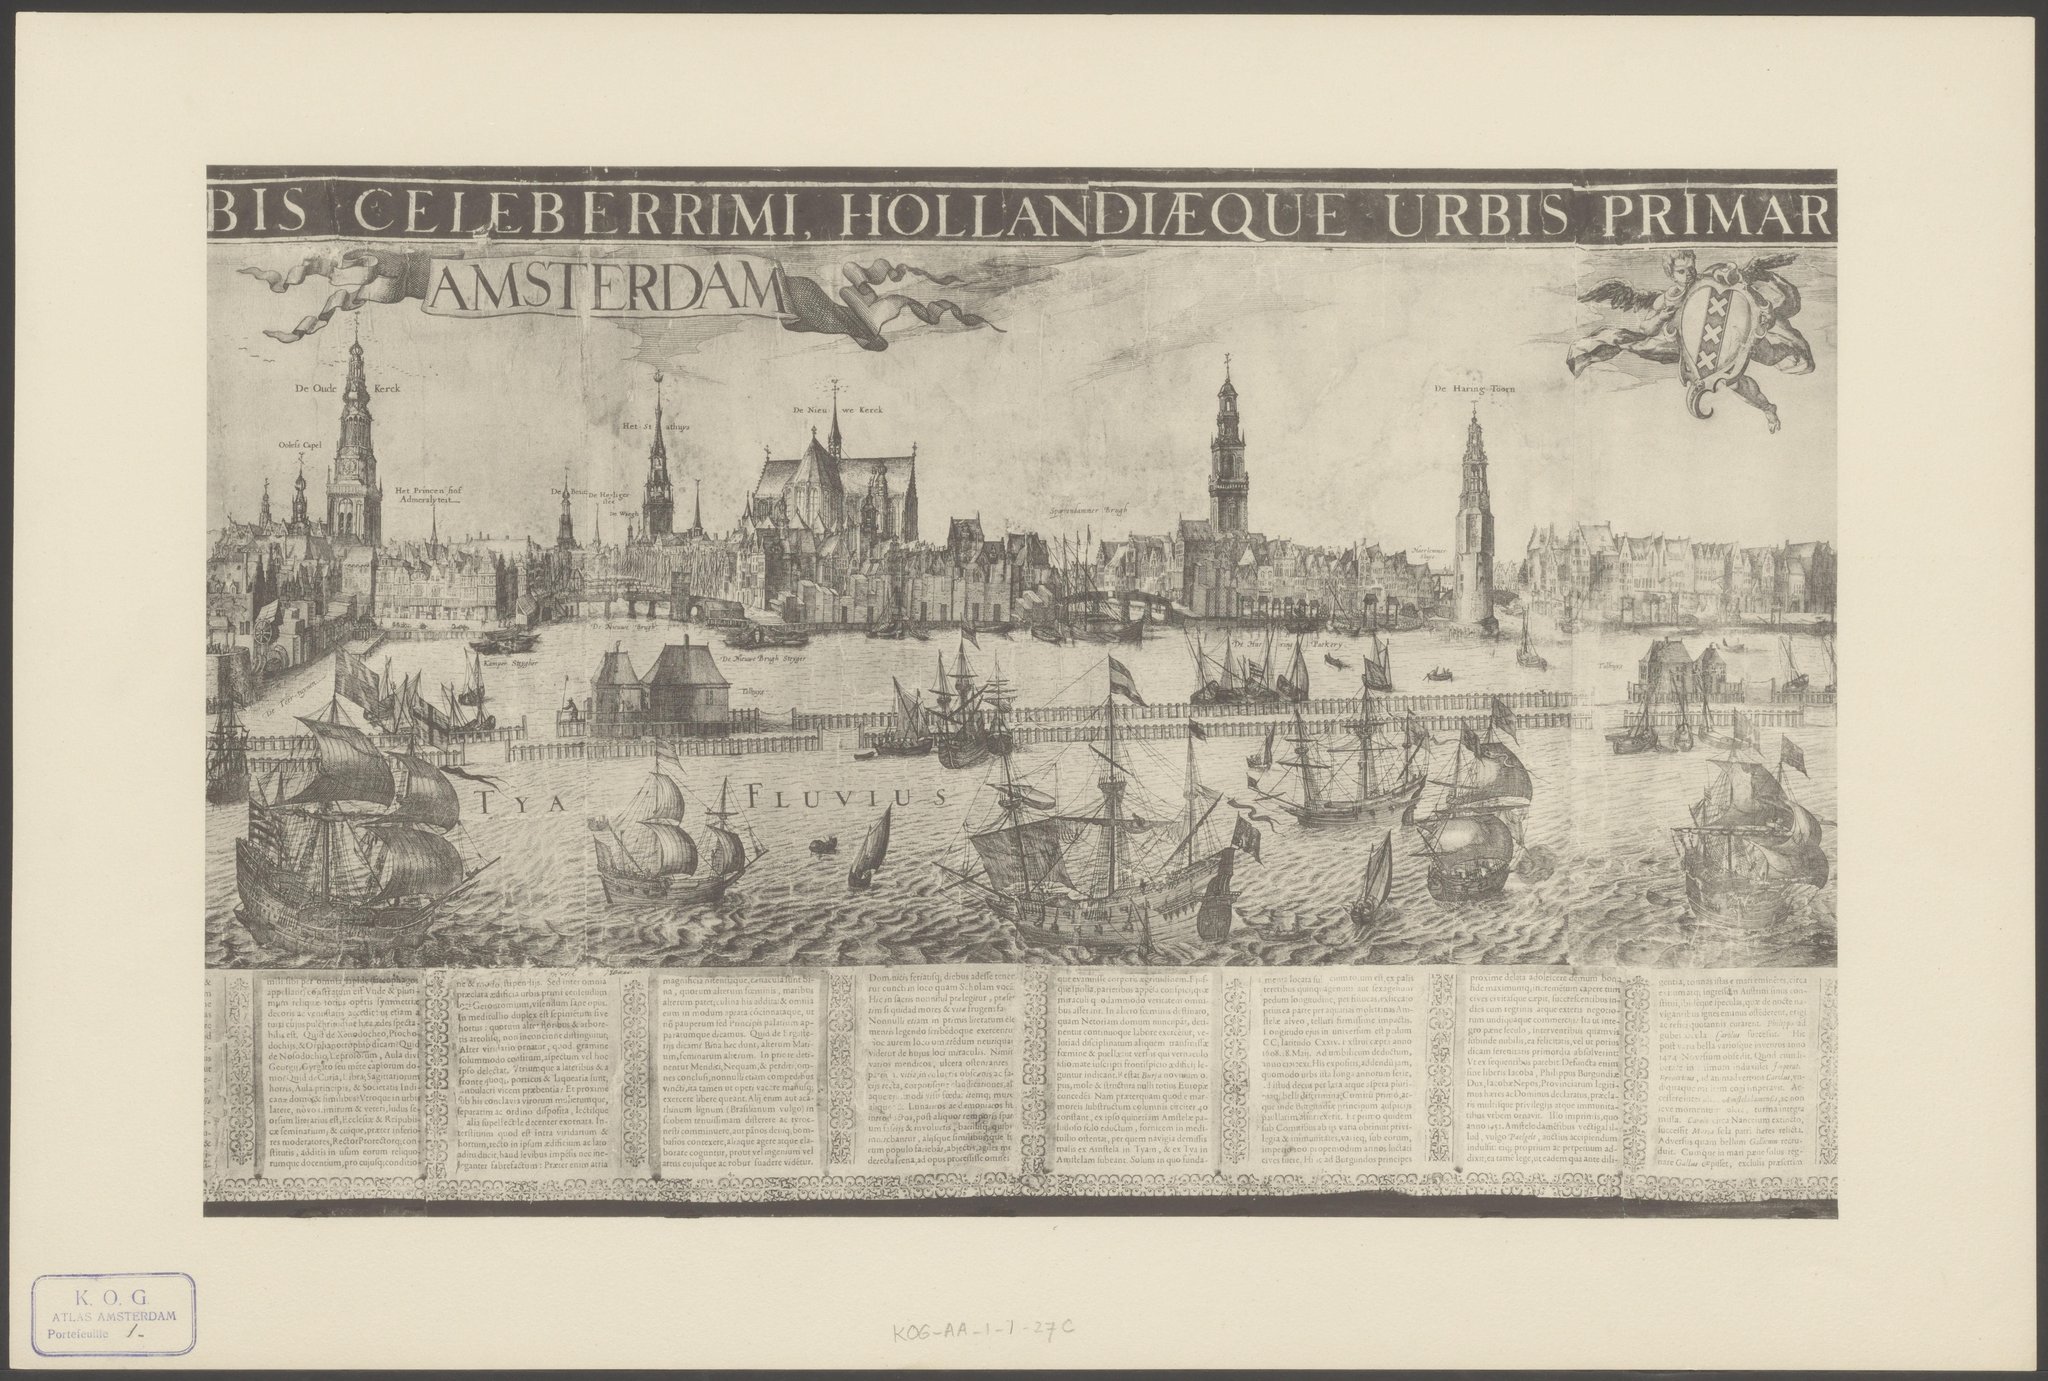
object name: photomechanical print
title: Gezicht op de stad Amsterdam vanaf het IJ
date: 1913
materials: paper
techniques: photograph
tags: city-view in general; 'veduta', river, ships (in general) - cc - more than one ship, amsterdam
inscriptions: collector's mark: ‘1’ Lugt 1641b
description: Onderwerpsrubriek binnen de Atlas Amsterdam: Gezichten van den geheelen IJkant der Stad.